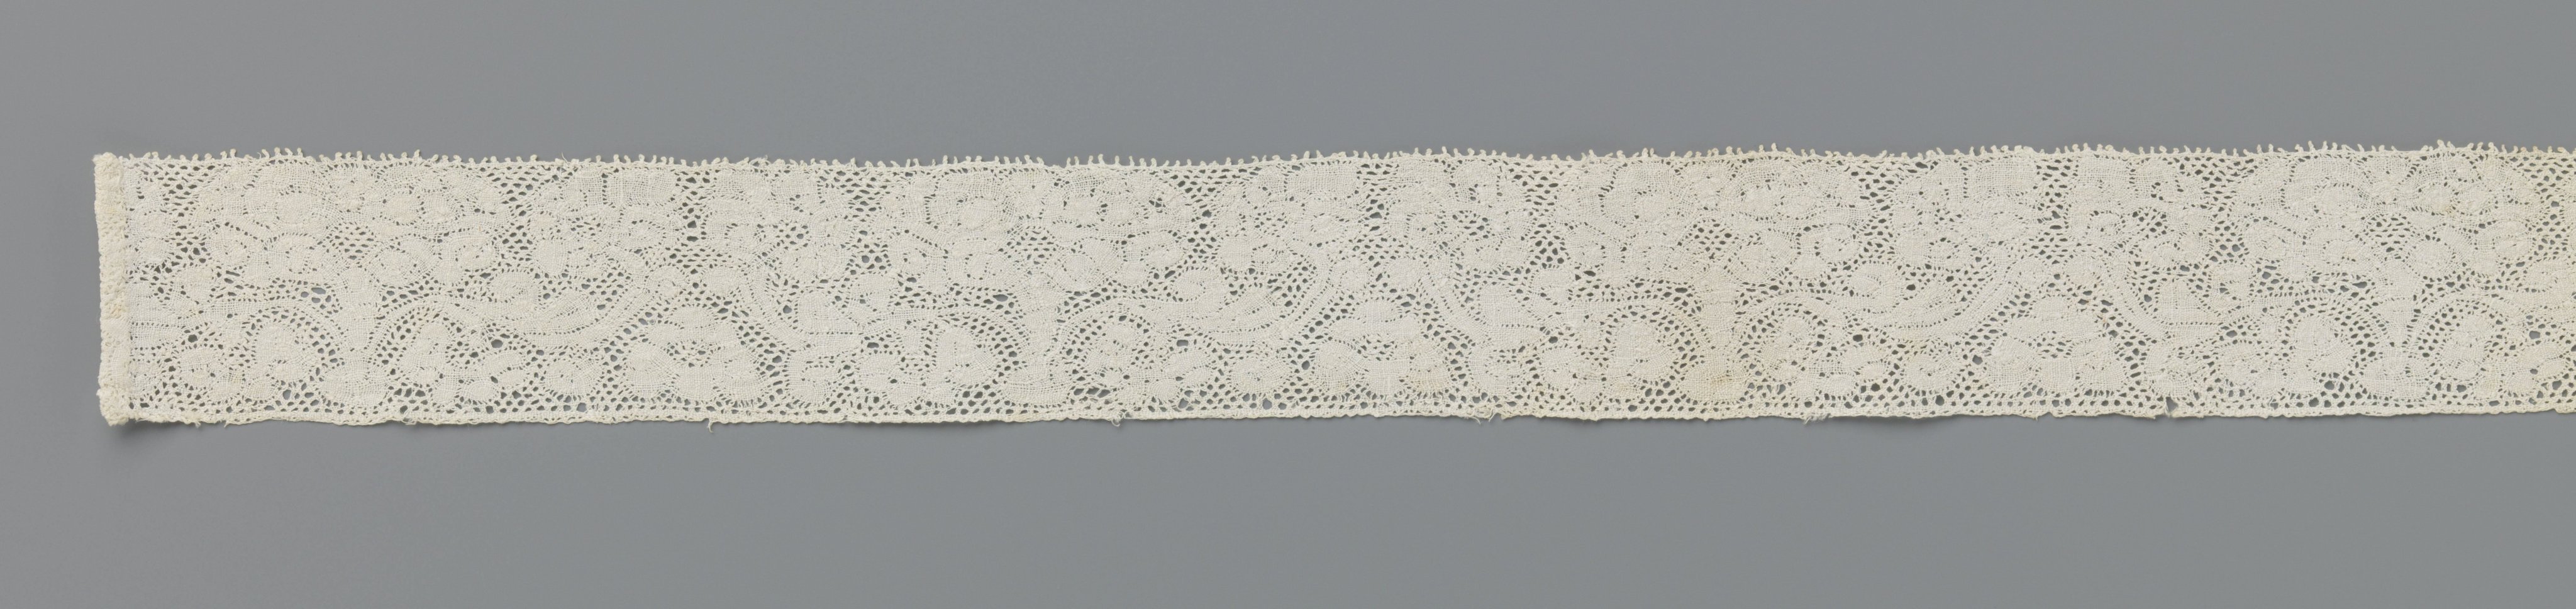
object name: strip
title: Strook kloskant met pioenroos tussen twee kleinere pioenrozen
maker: Anonymous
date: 1650-1660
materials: linen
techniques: lace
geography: antwerp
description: Strook naturelkleurige Hollandse kloskant. Het patroon bestaat uit een zich herhalend symmetrisch motief van een gestileerde pioenroos met links en rechts een golvende zijtak. Aan het eind van elke zijtak krult een kleinere pioenroos omhoog en richt zich naar de grote centrale bloem. De motieven zijn met elkaar verbonden door een ronde traliegrond met vlechtslagen. De motieven zijn gemaakt in linnenslag met opengewerkte randjes. De boven- en onderzijde van de strook zijn recht afgewerkt, met aan één zijde picots.